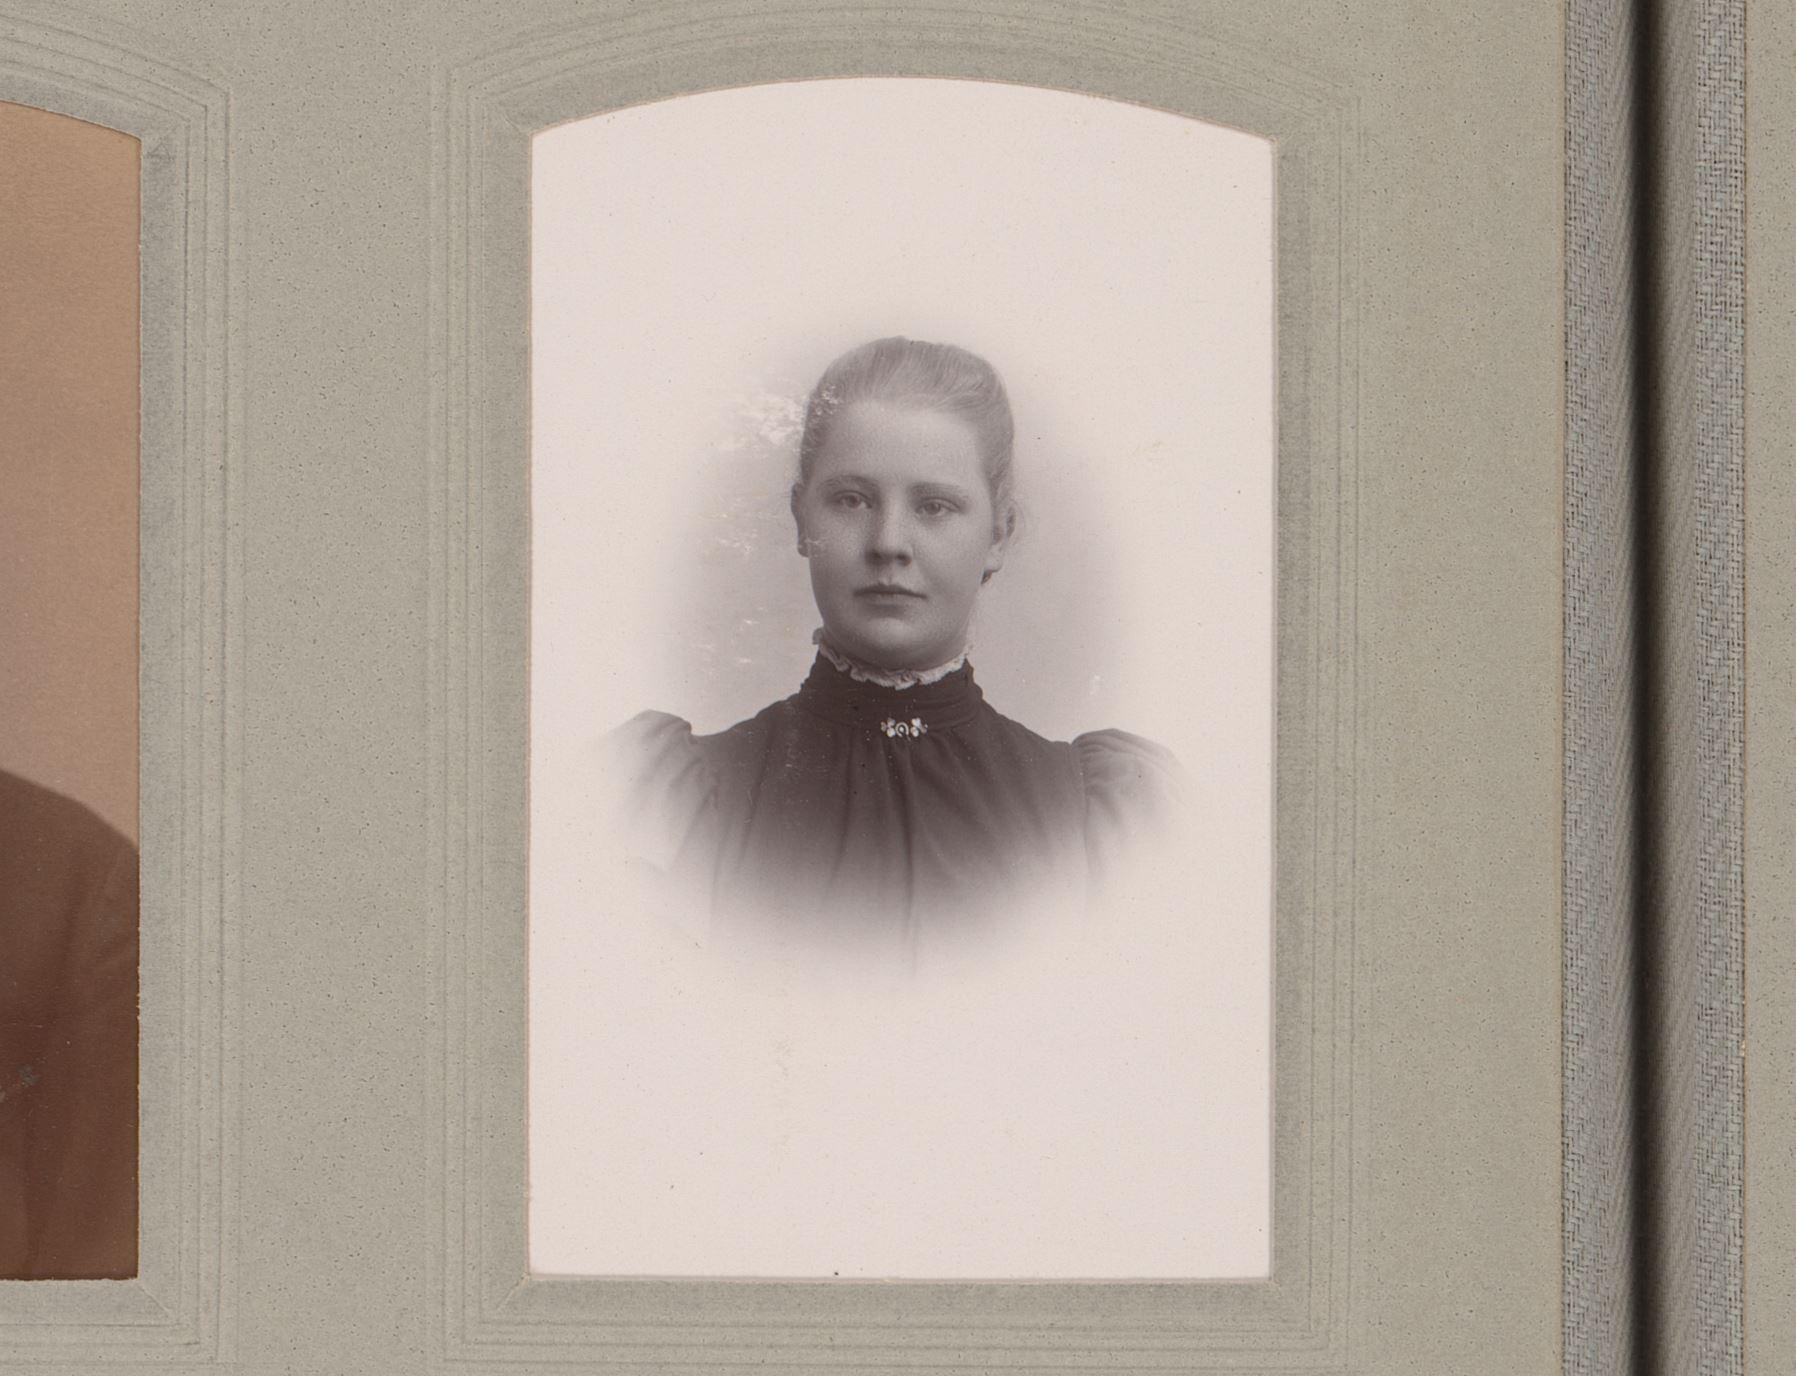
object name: photograph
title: Portret van een jonge vrouw in hooggesloten jurk met sieraad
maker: hedvig rosendahl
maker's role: fotograaf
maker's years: 1867-1929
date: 1880-1920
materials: cardboard, photographic support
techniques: collodion silver print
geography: stockholm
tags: adolescent, young woman, maiden, historical persons - bb - woman, necklace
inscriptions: inscription: ‘Allm. Telef. 107 78./ Hedvig Rosendahls/ Atelier/ Stockholm/ Drotninggatan 42./ Plåten förvaras för efterbeställning.’